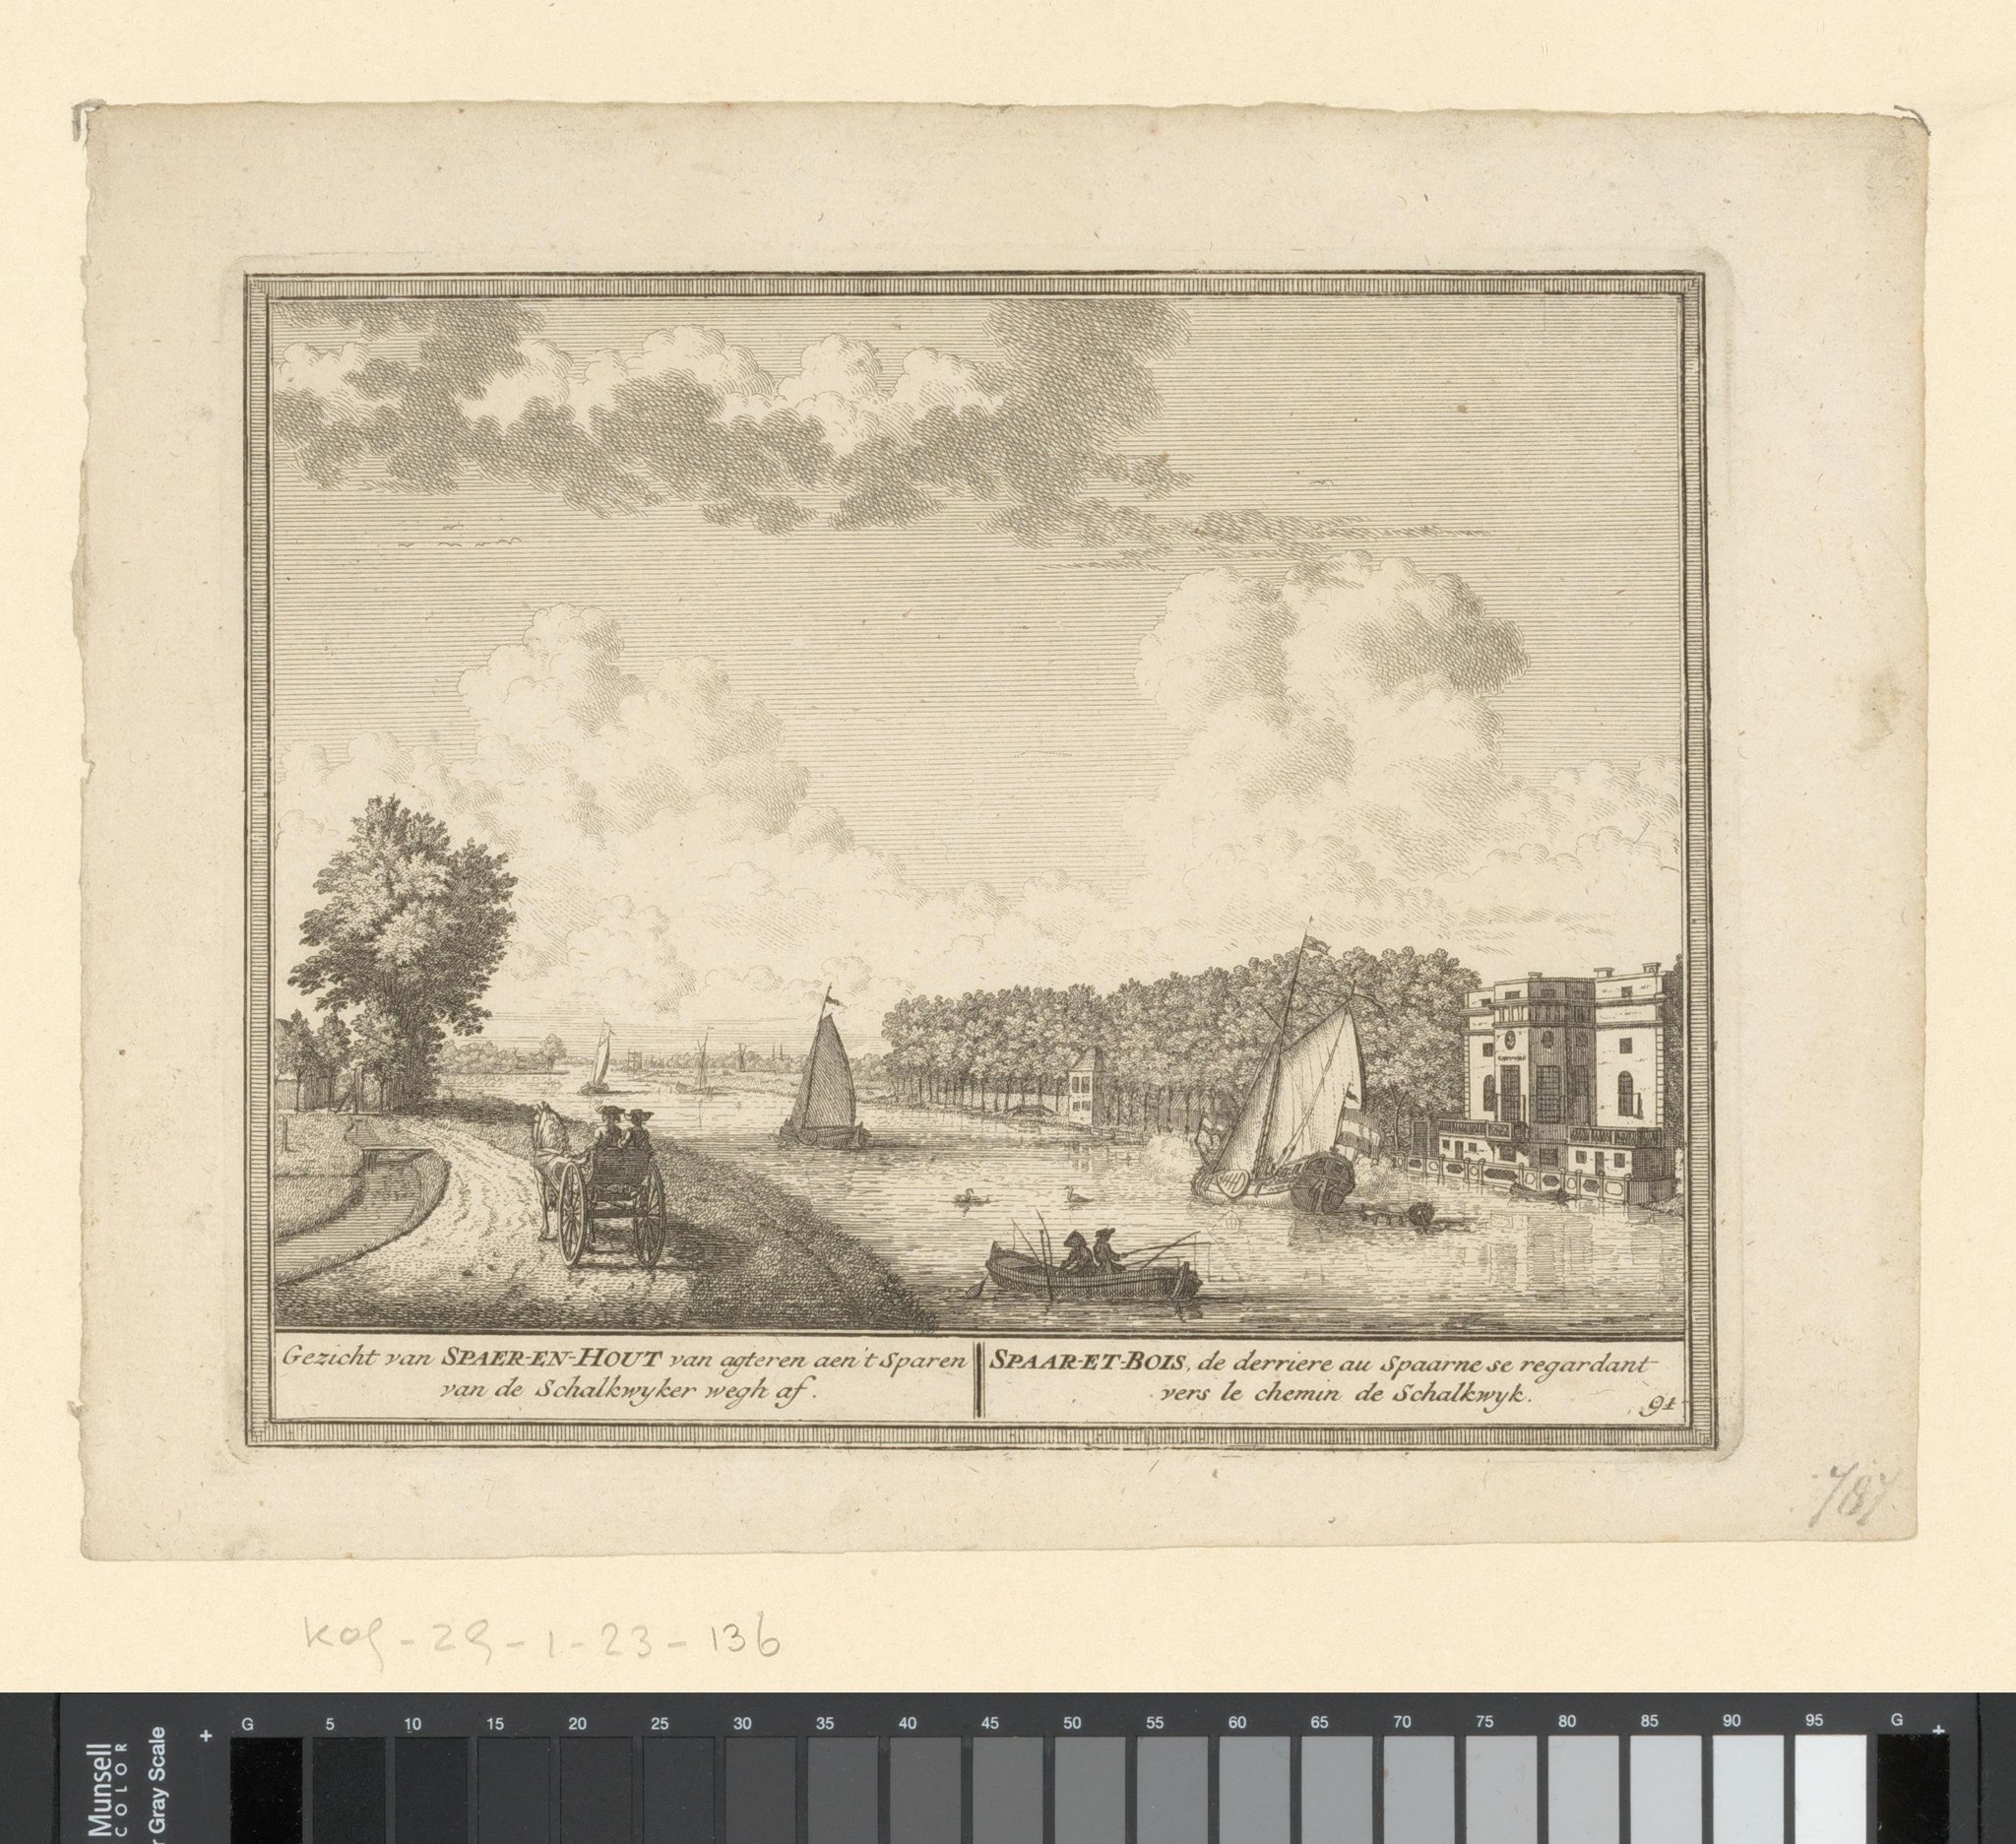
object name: print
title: Gezicht van Spaer-en-Hout van agteren aen 't Sparen van de Schalkwijker wegh af / Spaar-et-Bois, de derriere au Spaarne se regardant vers le chemin de Schalkwijk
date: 1735-1742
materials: paper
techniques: etching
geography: amsterdam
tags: gate, entrance, country-house, haarlem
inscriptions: collector's mark: Lugt 1641, stamp, stamp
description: Rechtsonder genummerd: 91. Onderwerpsrubrieken binnen de Atlas Zeden en Gewoonten: Zeden en Gewoonten in Engeren Zin, De Woning. Kastelen en buitenplaatsen. Holland (vervolg.)